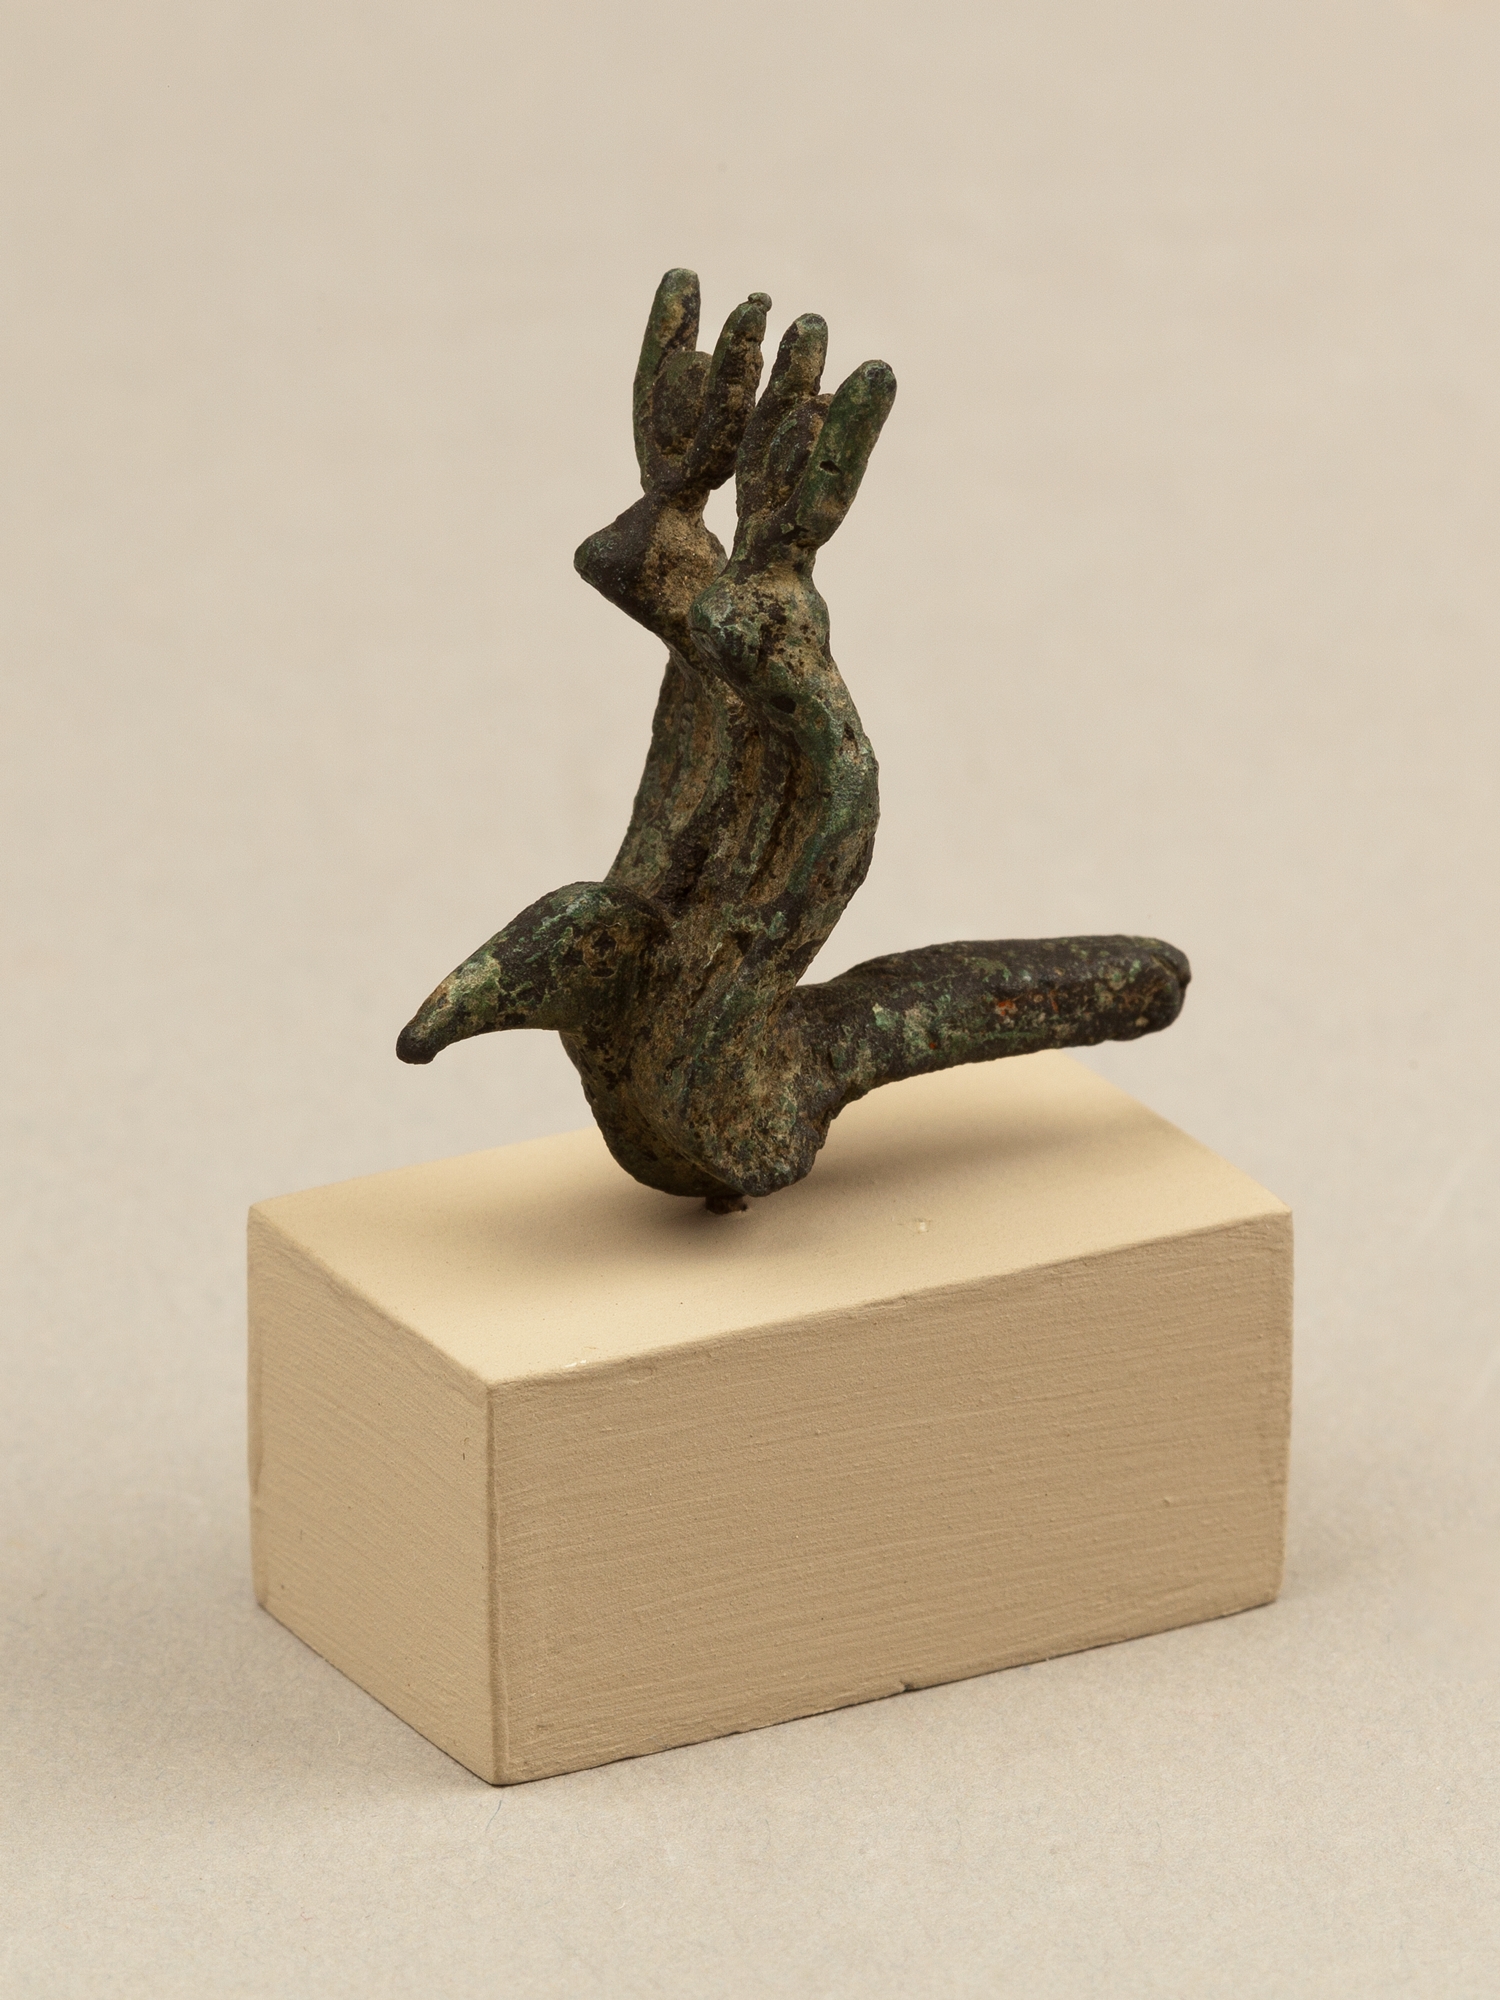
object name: statue, double uraeus, vulture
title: Vulture head and double uraei with disk and horn crowns, from statue of a goddess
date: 664-630 BCE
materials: metal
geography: egypt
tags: birds